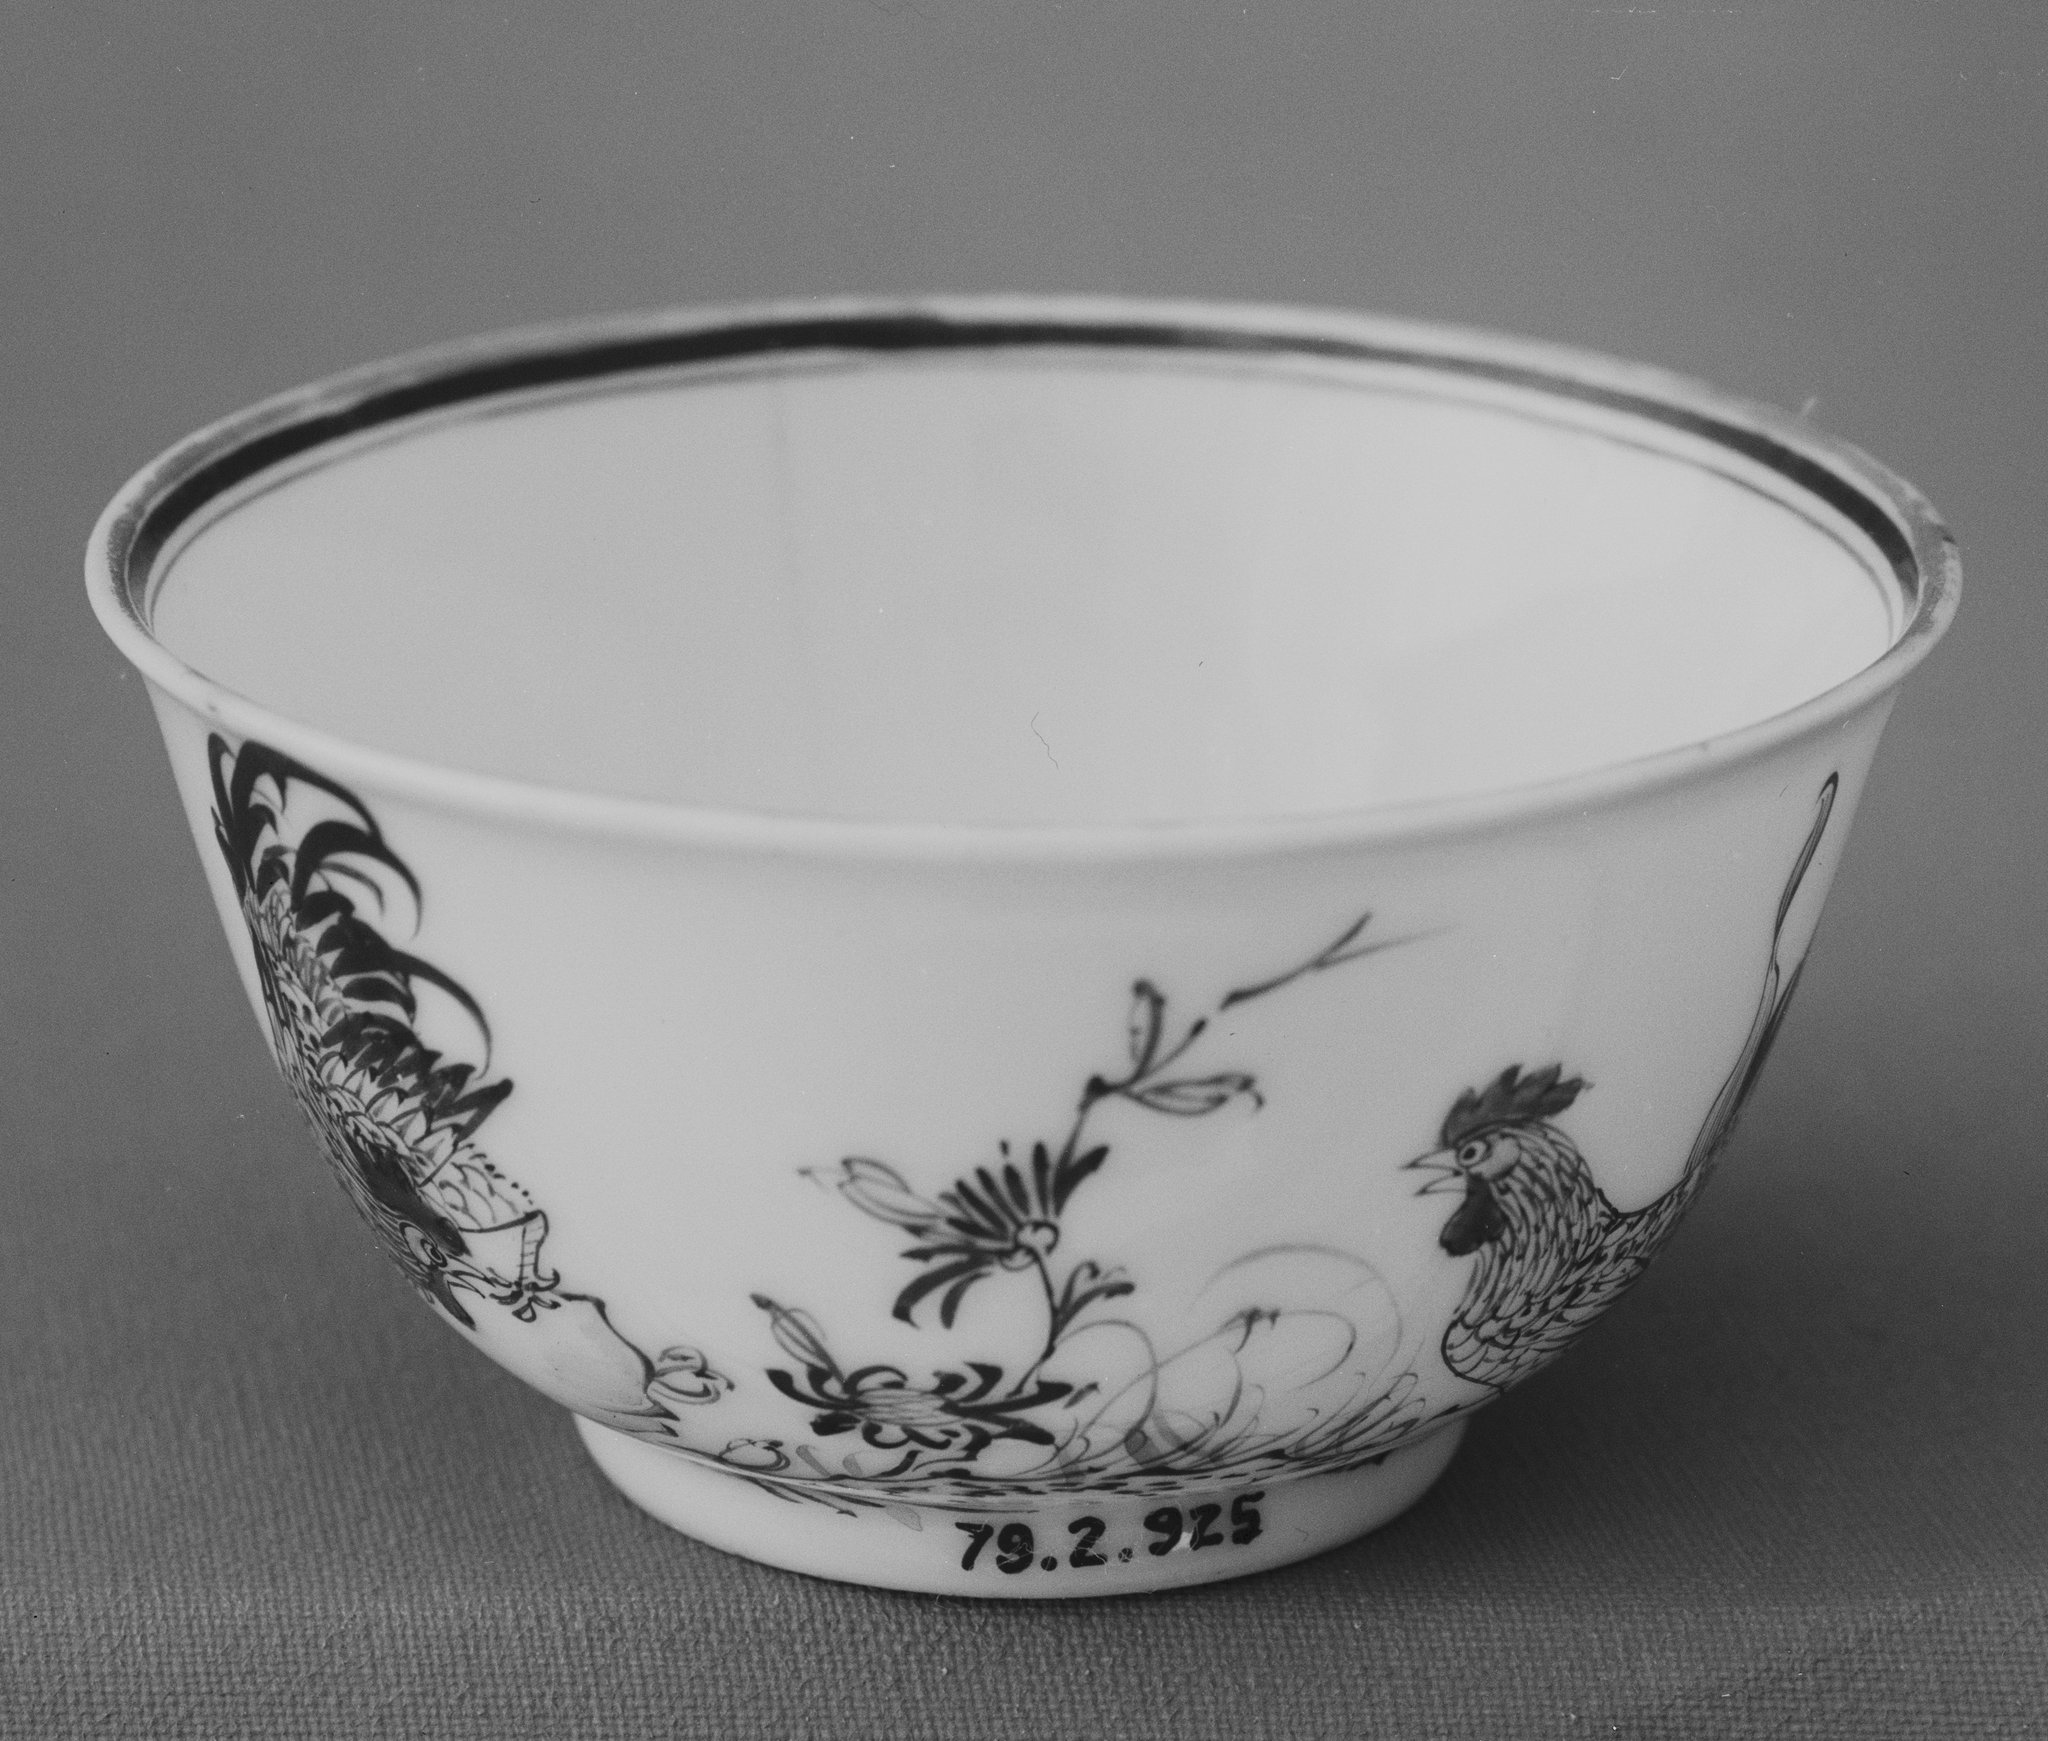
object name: cup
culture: chinese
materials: enamel, gilt, porcelain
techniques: overglaze, painting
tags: roosters,flowers